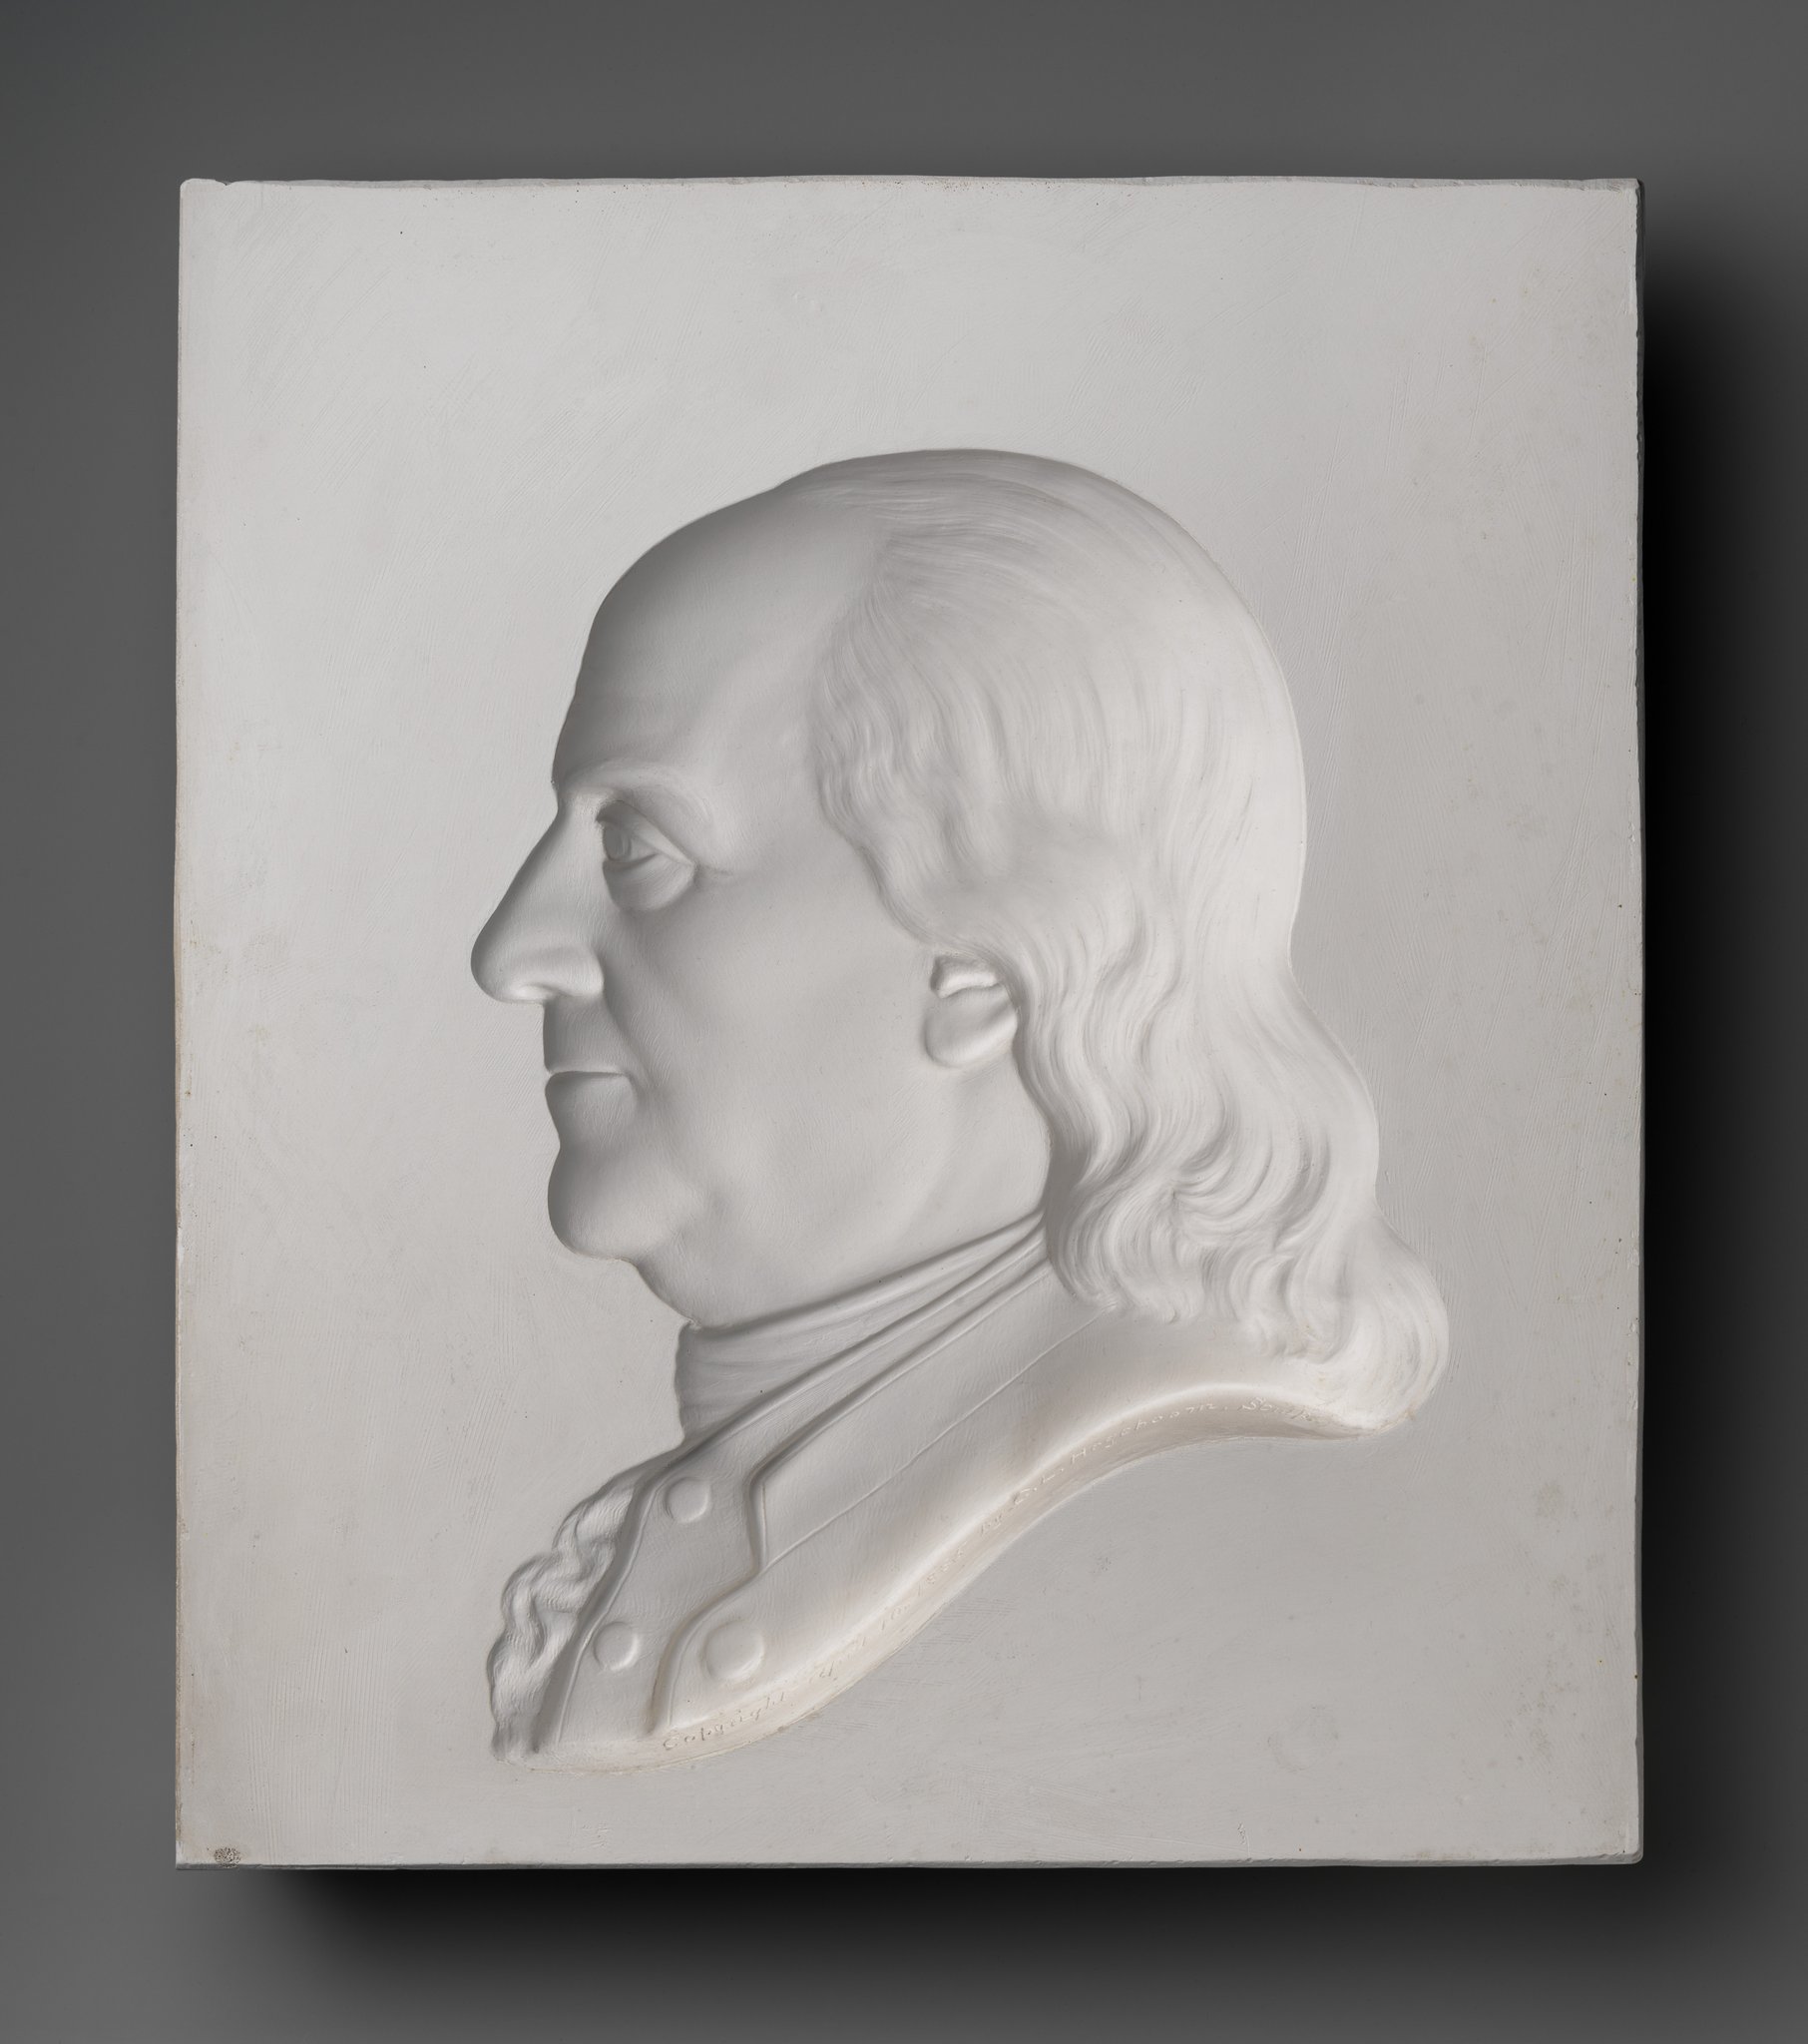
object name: bust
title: Benjamin Franklin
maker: charles l. hogeboom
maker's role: artist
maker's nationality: american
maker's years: 1827-1895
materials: plaster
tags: benjamin franklin